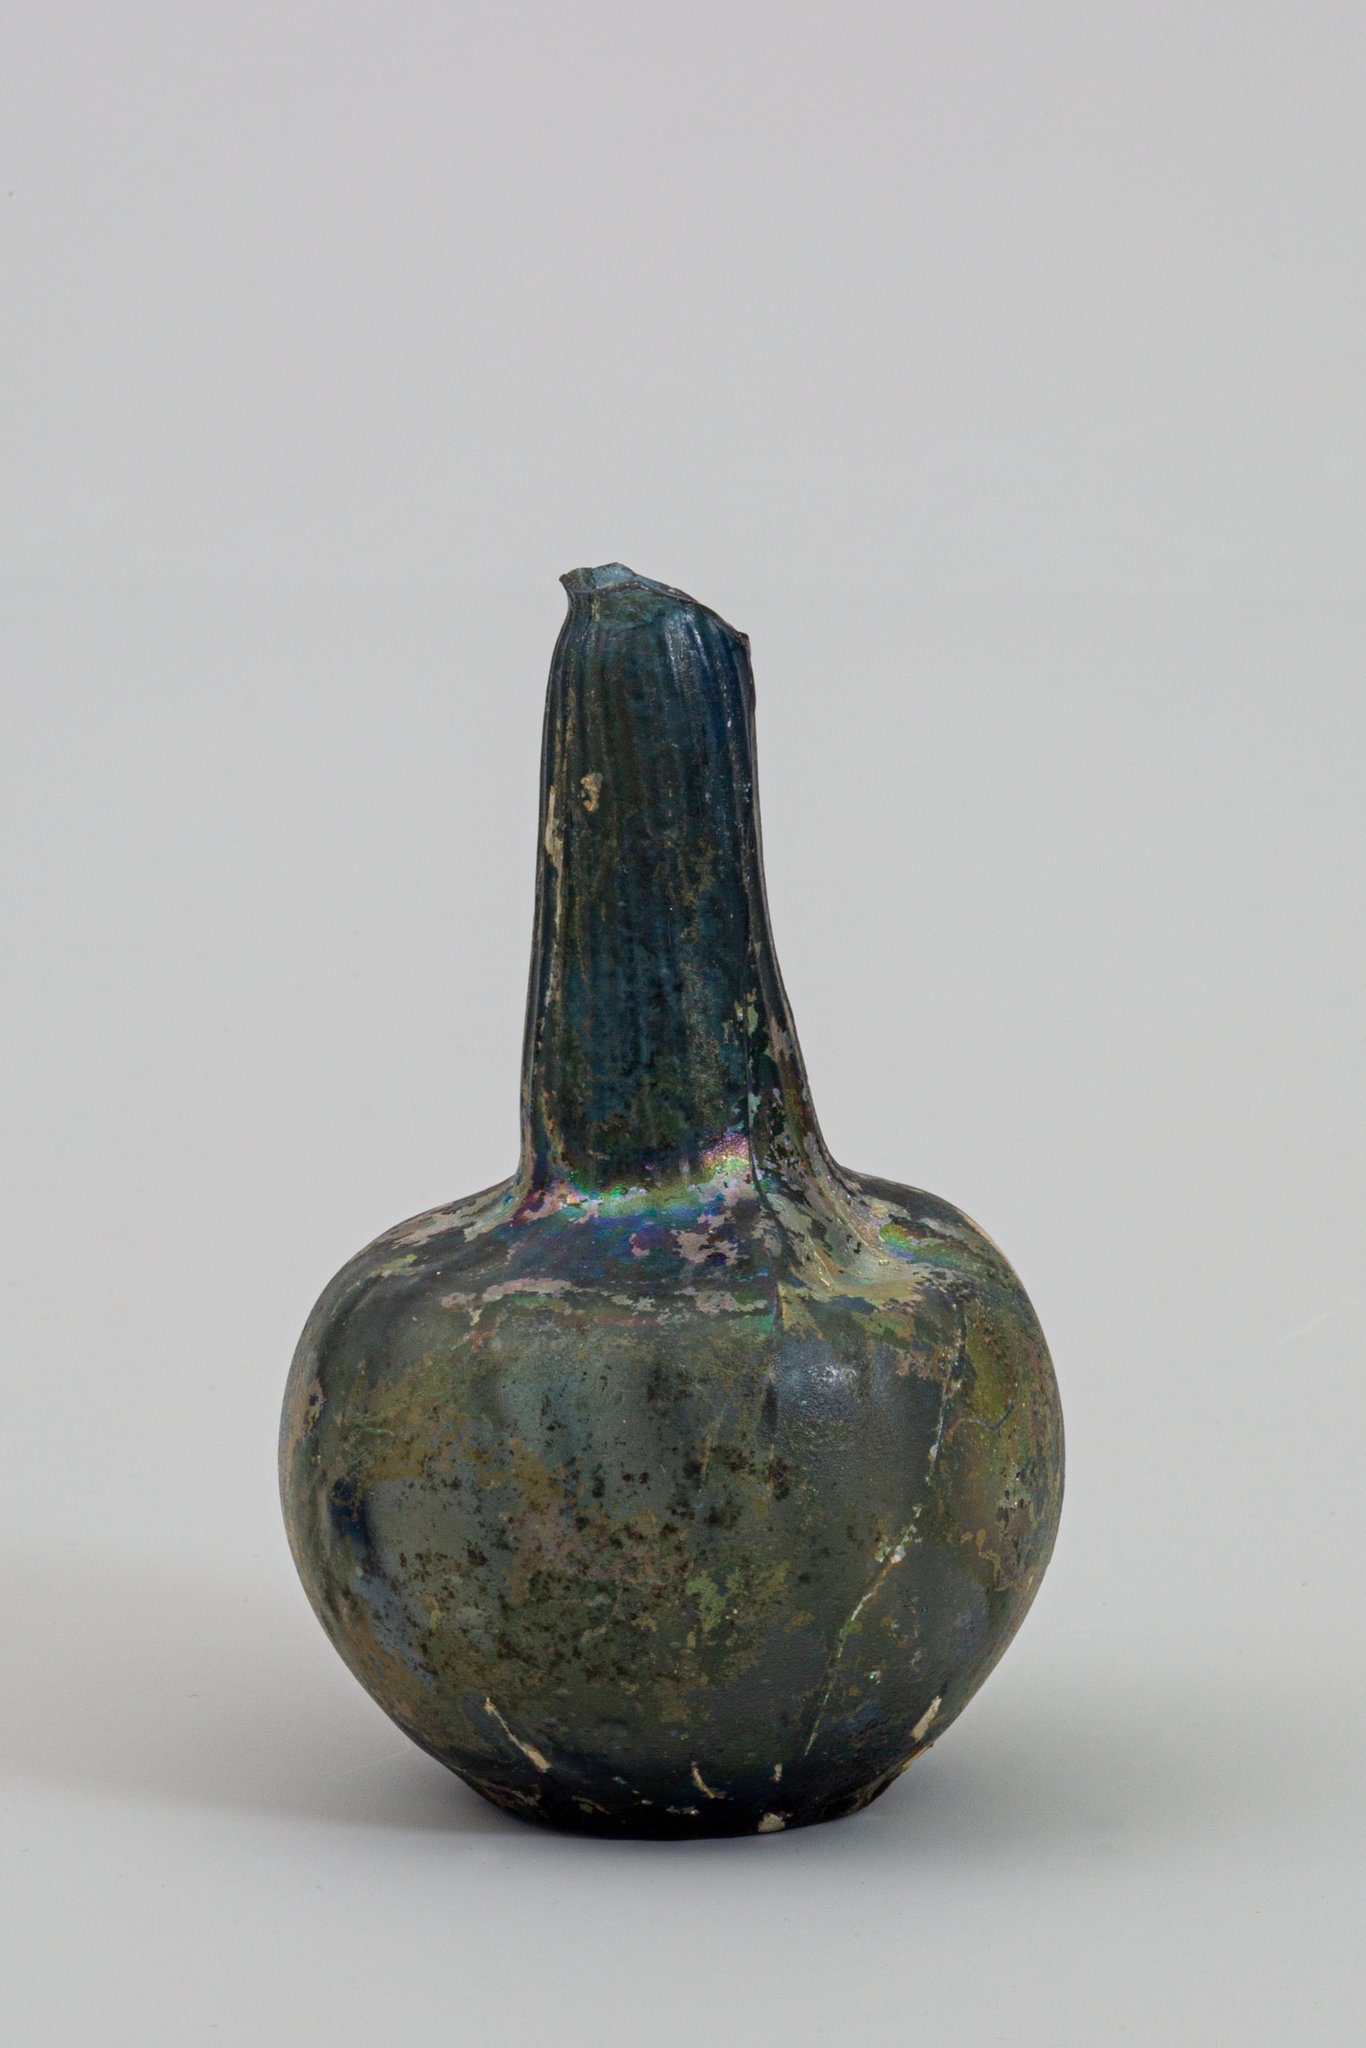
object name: perfume bottle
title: Glass perfume bottle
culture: islamic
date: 701-900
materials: glass